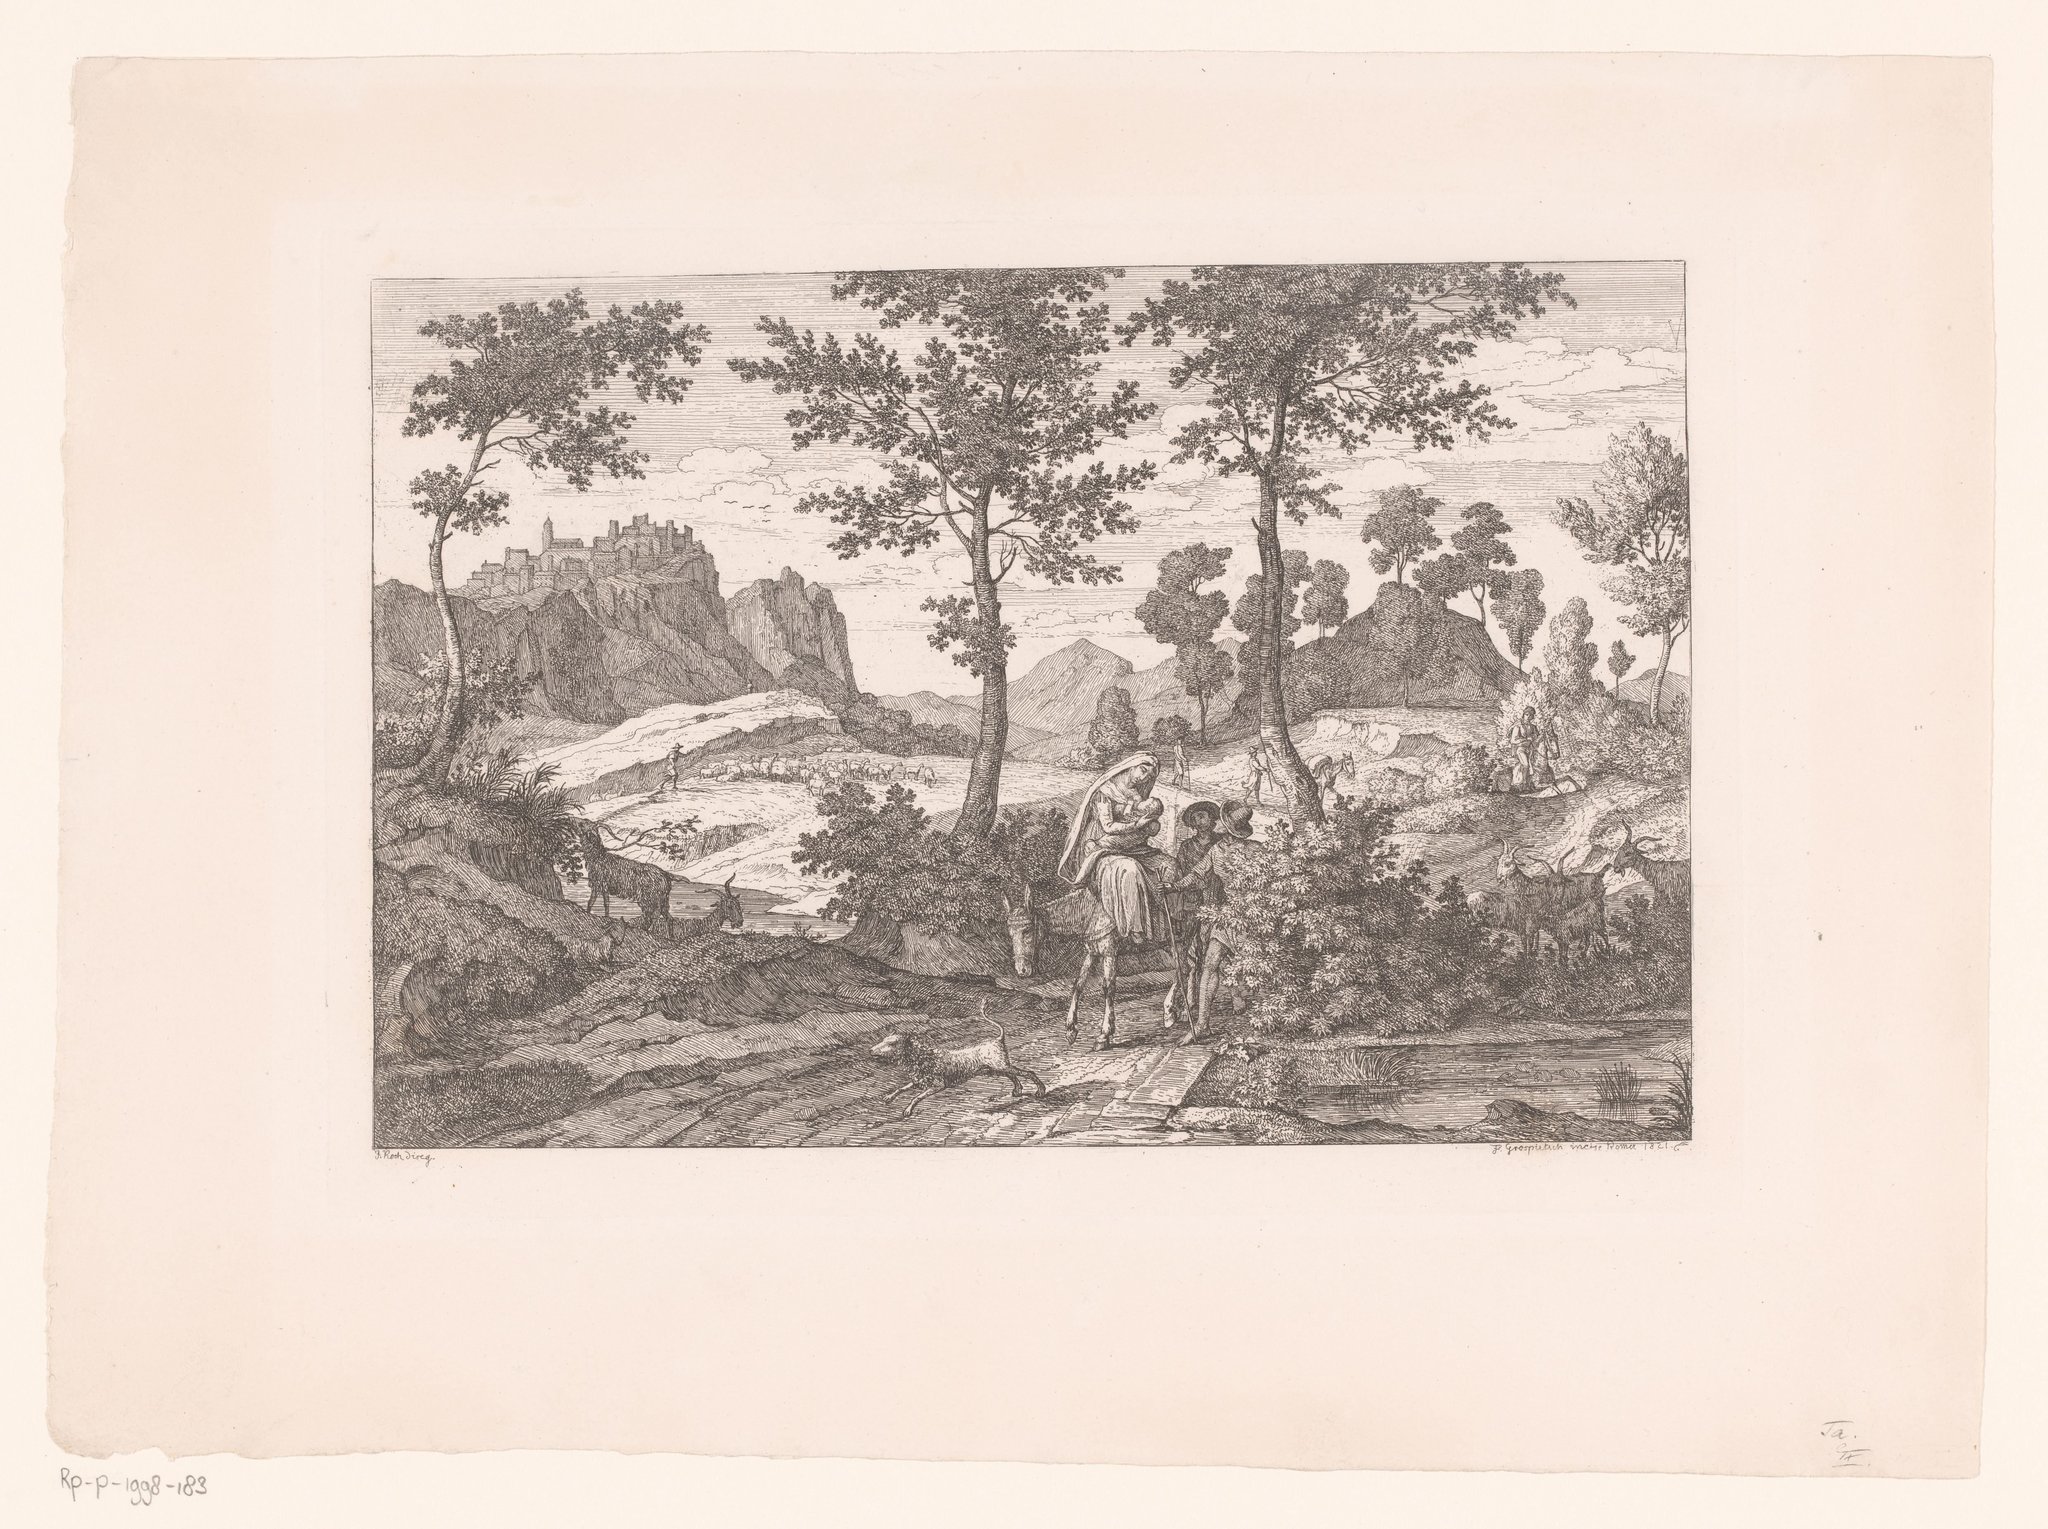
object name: print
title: Landschap bij Civitella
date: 1821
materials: paper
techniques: etching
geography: rome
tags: city-view, and landscape with man-made constructions, landscapes, nursing, suckling, ass, donkey, herding, herdsman, herdswoman, shepherd, shepherdess, cowherd, etc., dog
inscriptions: collector's mark: Lugt 1606, collector's mark: Lugt 2482, collector's mark: Lugt 2228